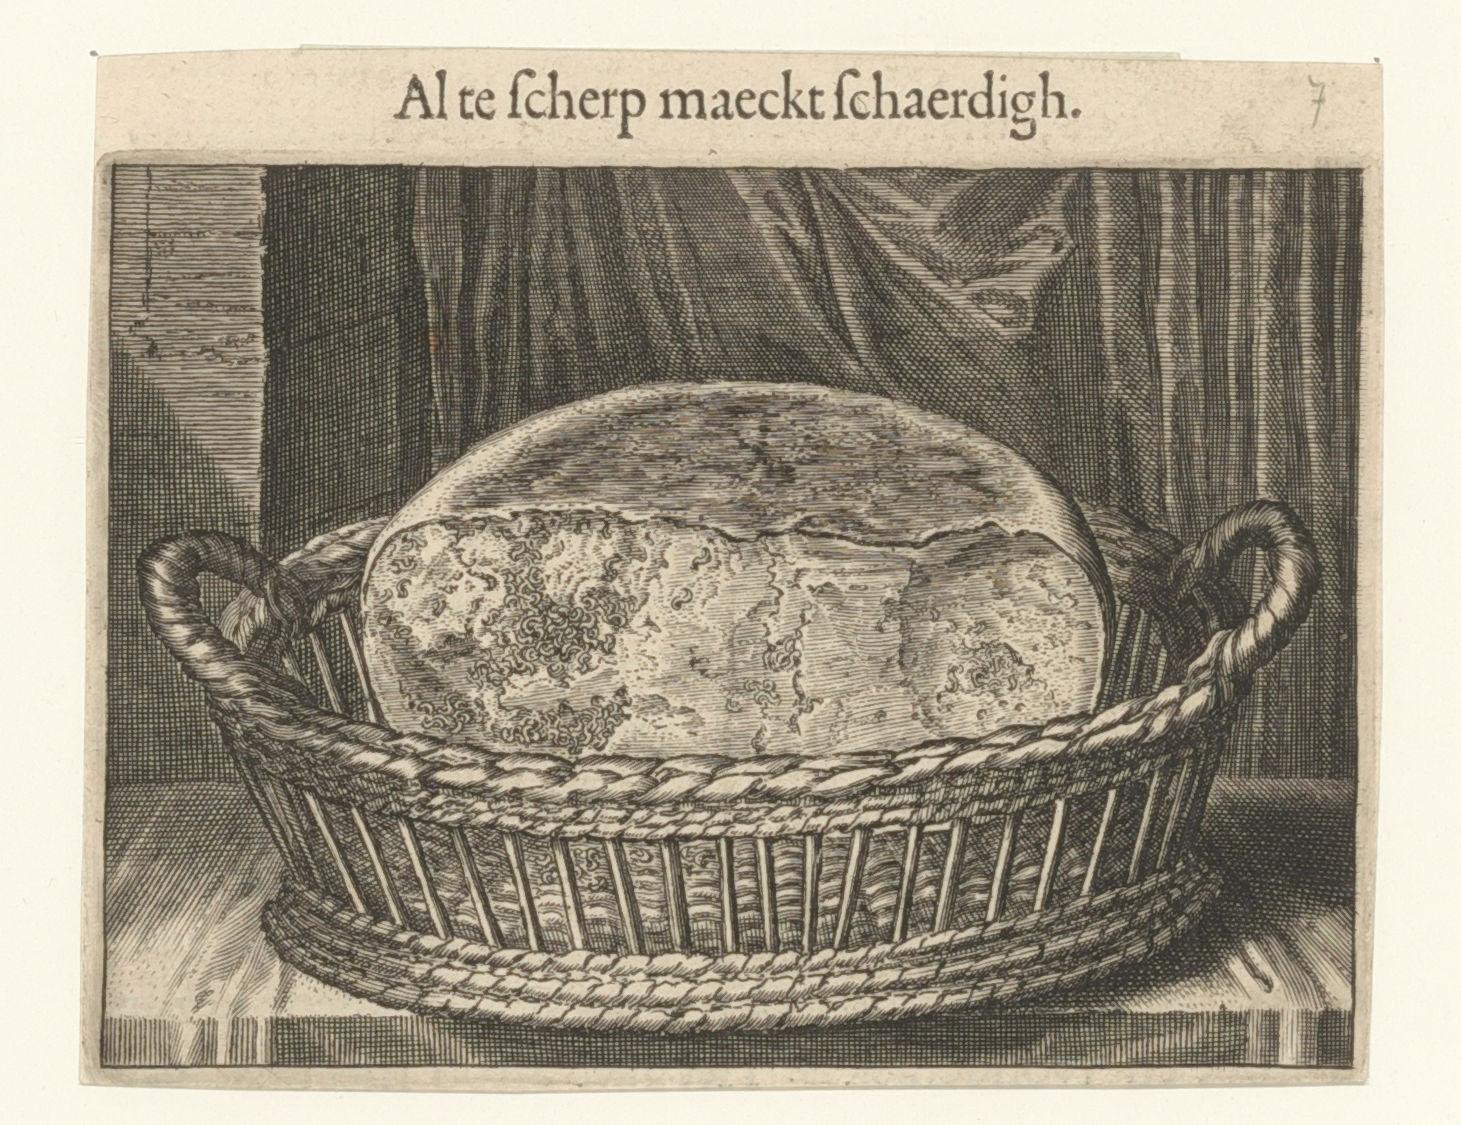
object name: book illustration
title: Kaas met krioelende wormen in een mand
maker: Anonymous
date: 1624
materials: paper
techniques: engraving, letterpress printing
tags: worms, adversity, misfortune, bad luck; 'fortuna infelice', 'infortunio' (ripa), container made of plant material other than wood: basket, intellect, intelligence; 'intelletto', 'intelligenza' (ripa), proverbs, sayings, etc., cheese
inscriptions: collector's mark: Lugt 1641, stamp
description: Embleem uit: Brune, Johan de. Zinne-werck, Voor-ghesyelt in Beelden, Ghedichten, ende breeder uyt-legginghen (...). Amsterdam: Evertsen Kloppenburch, 1624. Prent ook gebruikt in latere edities (1636 en 1661).